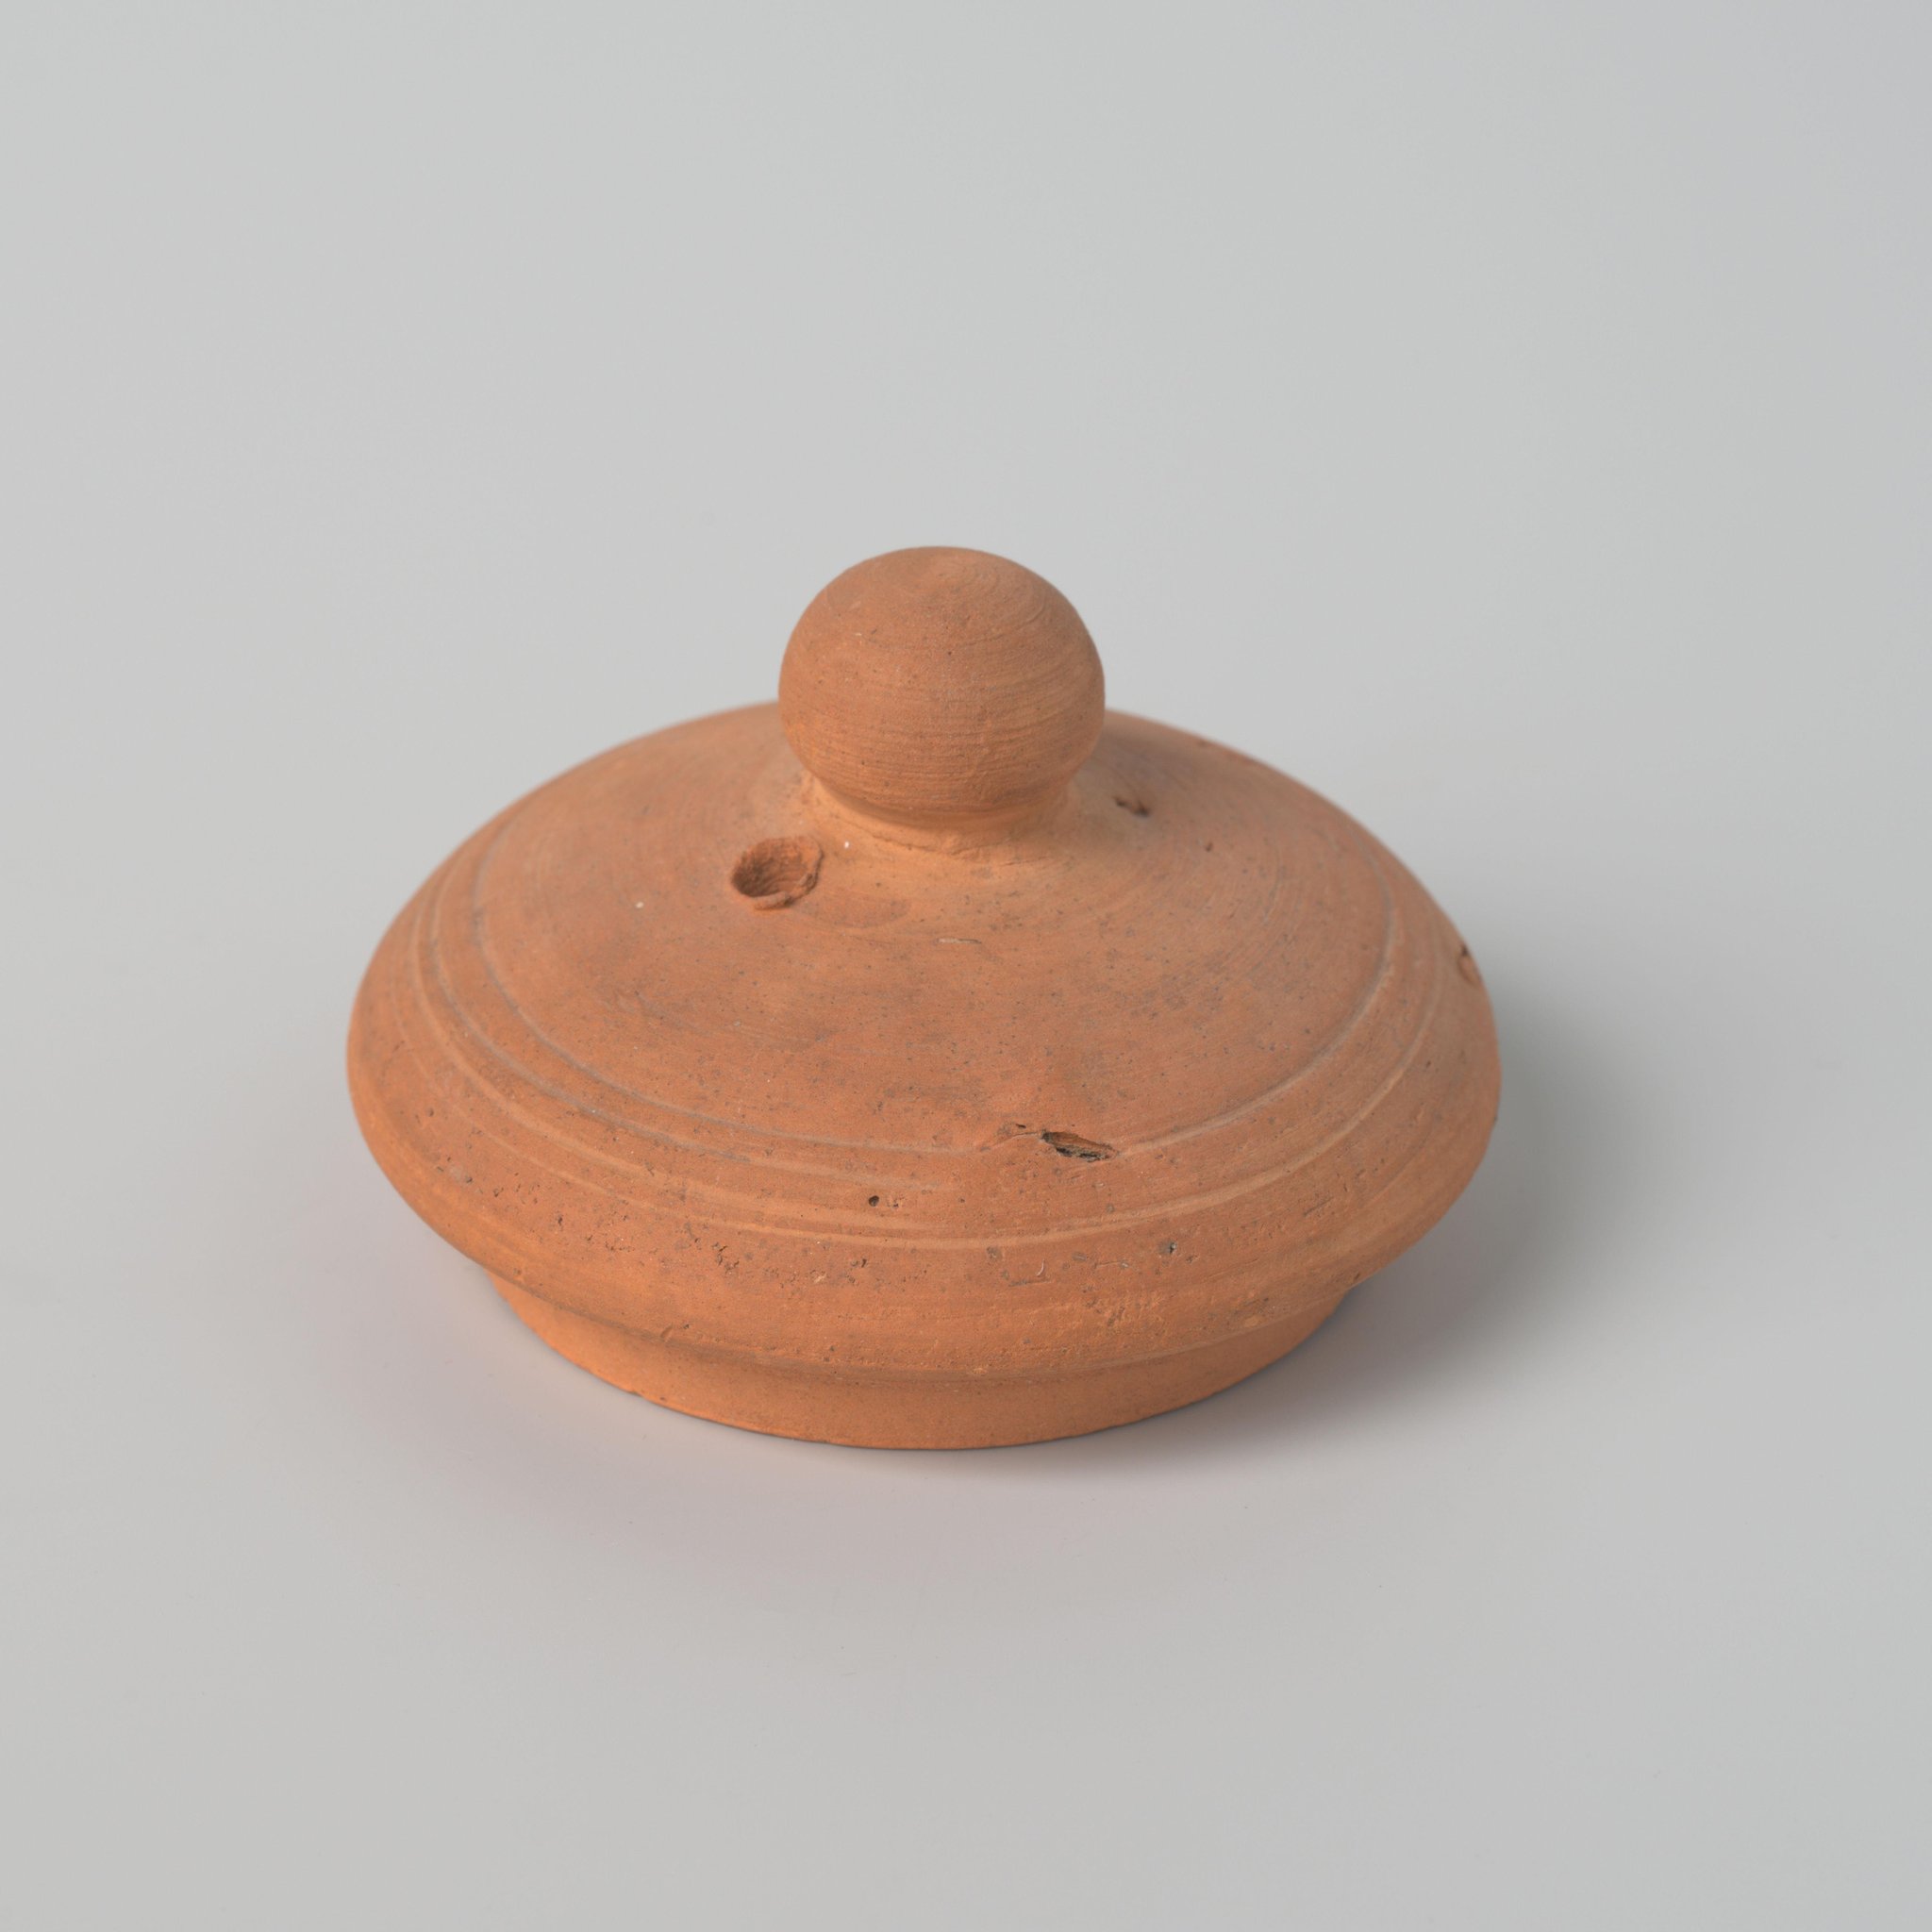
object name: lid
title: Deksel van een theepot (De Caluwe bakafval)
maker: jacobus de caluwe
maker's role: plateelbakkerij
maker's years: -1730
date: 1700-1725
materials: earthenware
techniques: firing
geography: delft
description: Toegeschreven aan Jacobus de Caluwe, omdat dit voorwerp samen met gemerkte stukken (‘Jacobus De Caluwe’ en rennend hert) gevonden is op de plaats waar zich De Caluwes tweede werkplaats bevond. Er is een duidelijke stilistische overeenkomst tussen de gemerkte en niet gemerkte voorwerpen uit deze archeologische vondst.